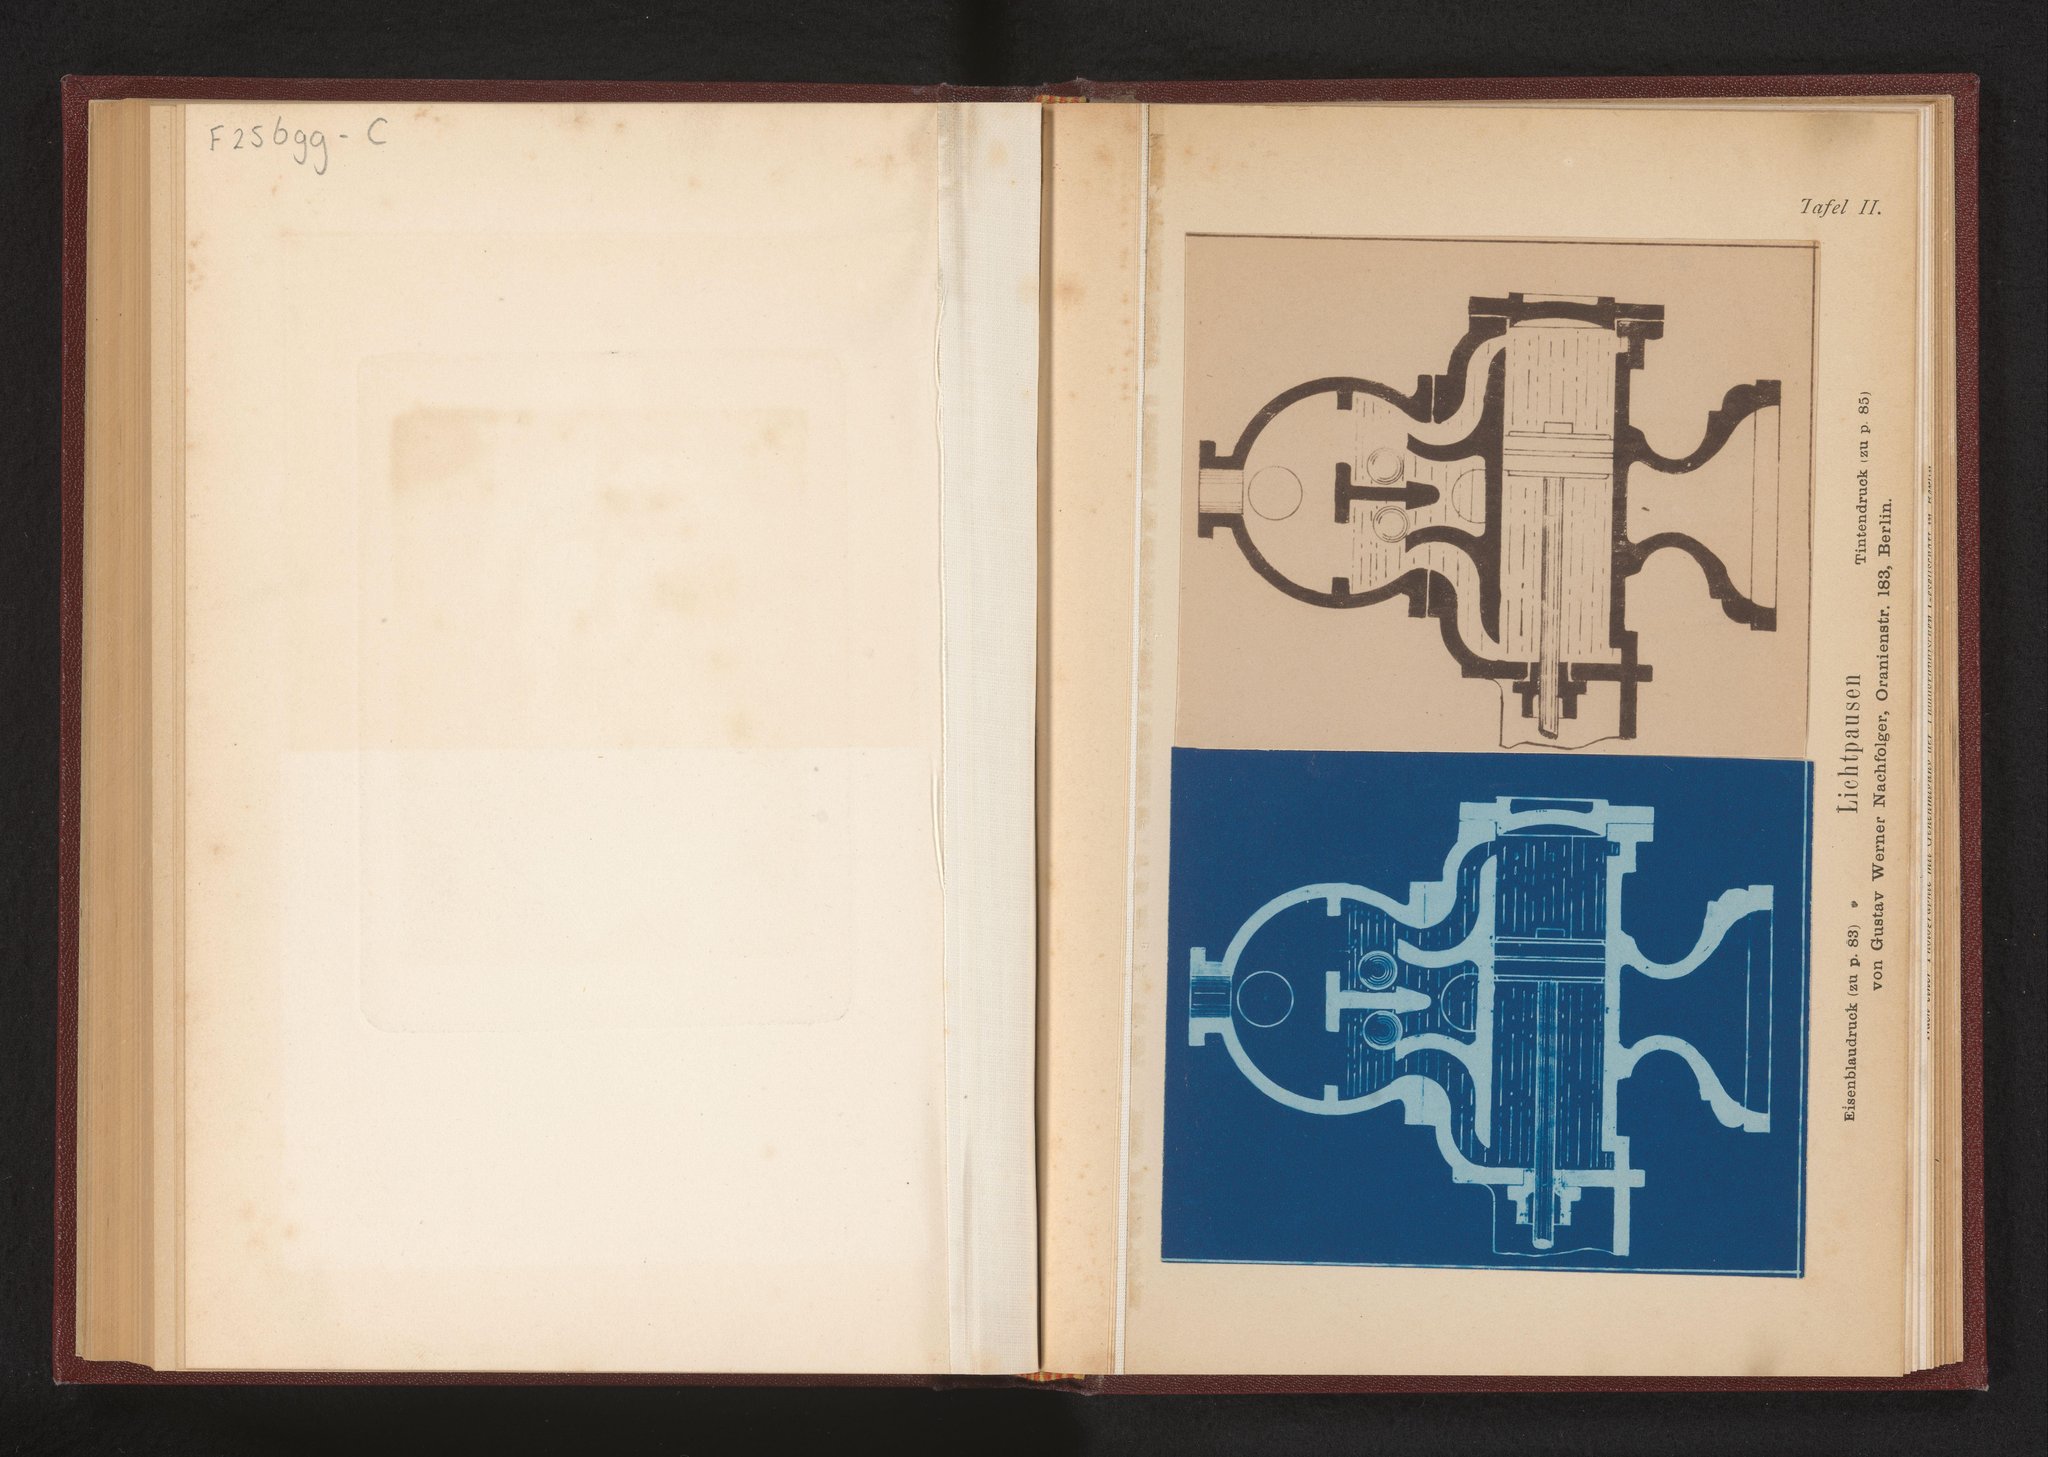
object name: photograph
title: Lichtpausen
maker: gustav werner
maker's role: fotograaf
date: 1885-1890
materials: paper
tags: parts of machines, section ~ architectural design or model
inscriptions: number: ‘Tafel II.’, inscription: ‘Tintendruck (zu p. 85)’, inscription: ‘von Gustav Werner Nachfolger, Oranienstr. 183, Berlin.’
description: Foto op derde ongenummerde pagina na pagina 351.